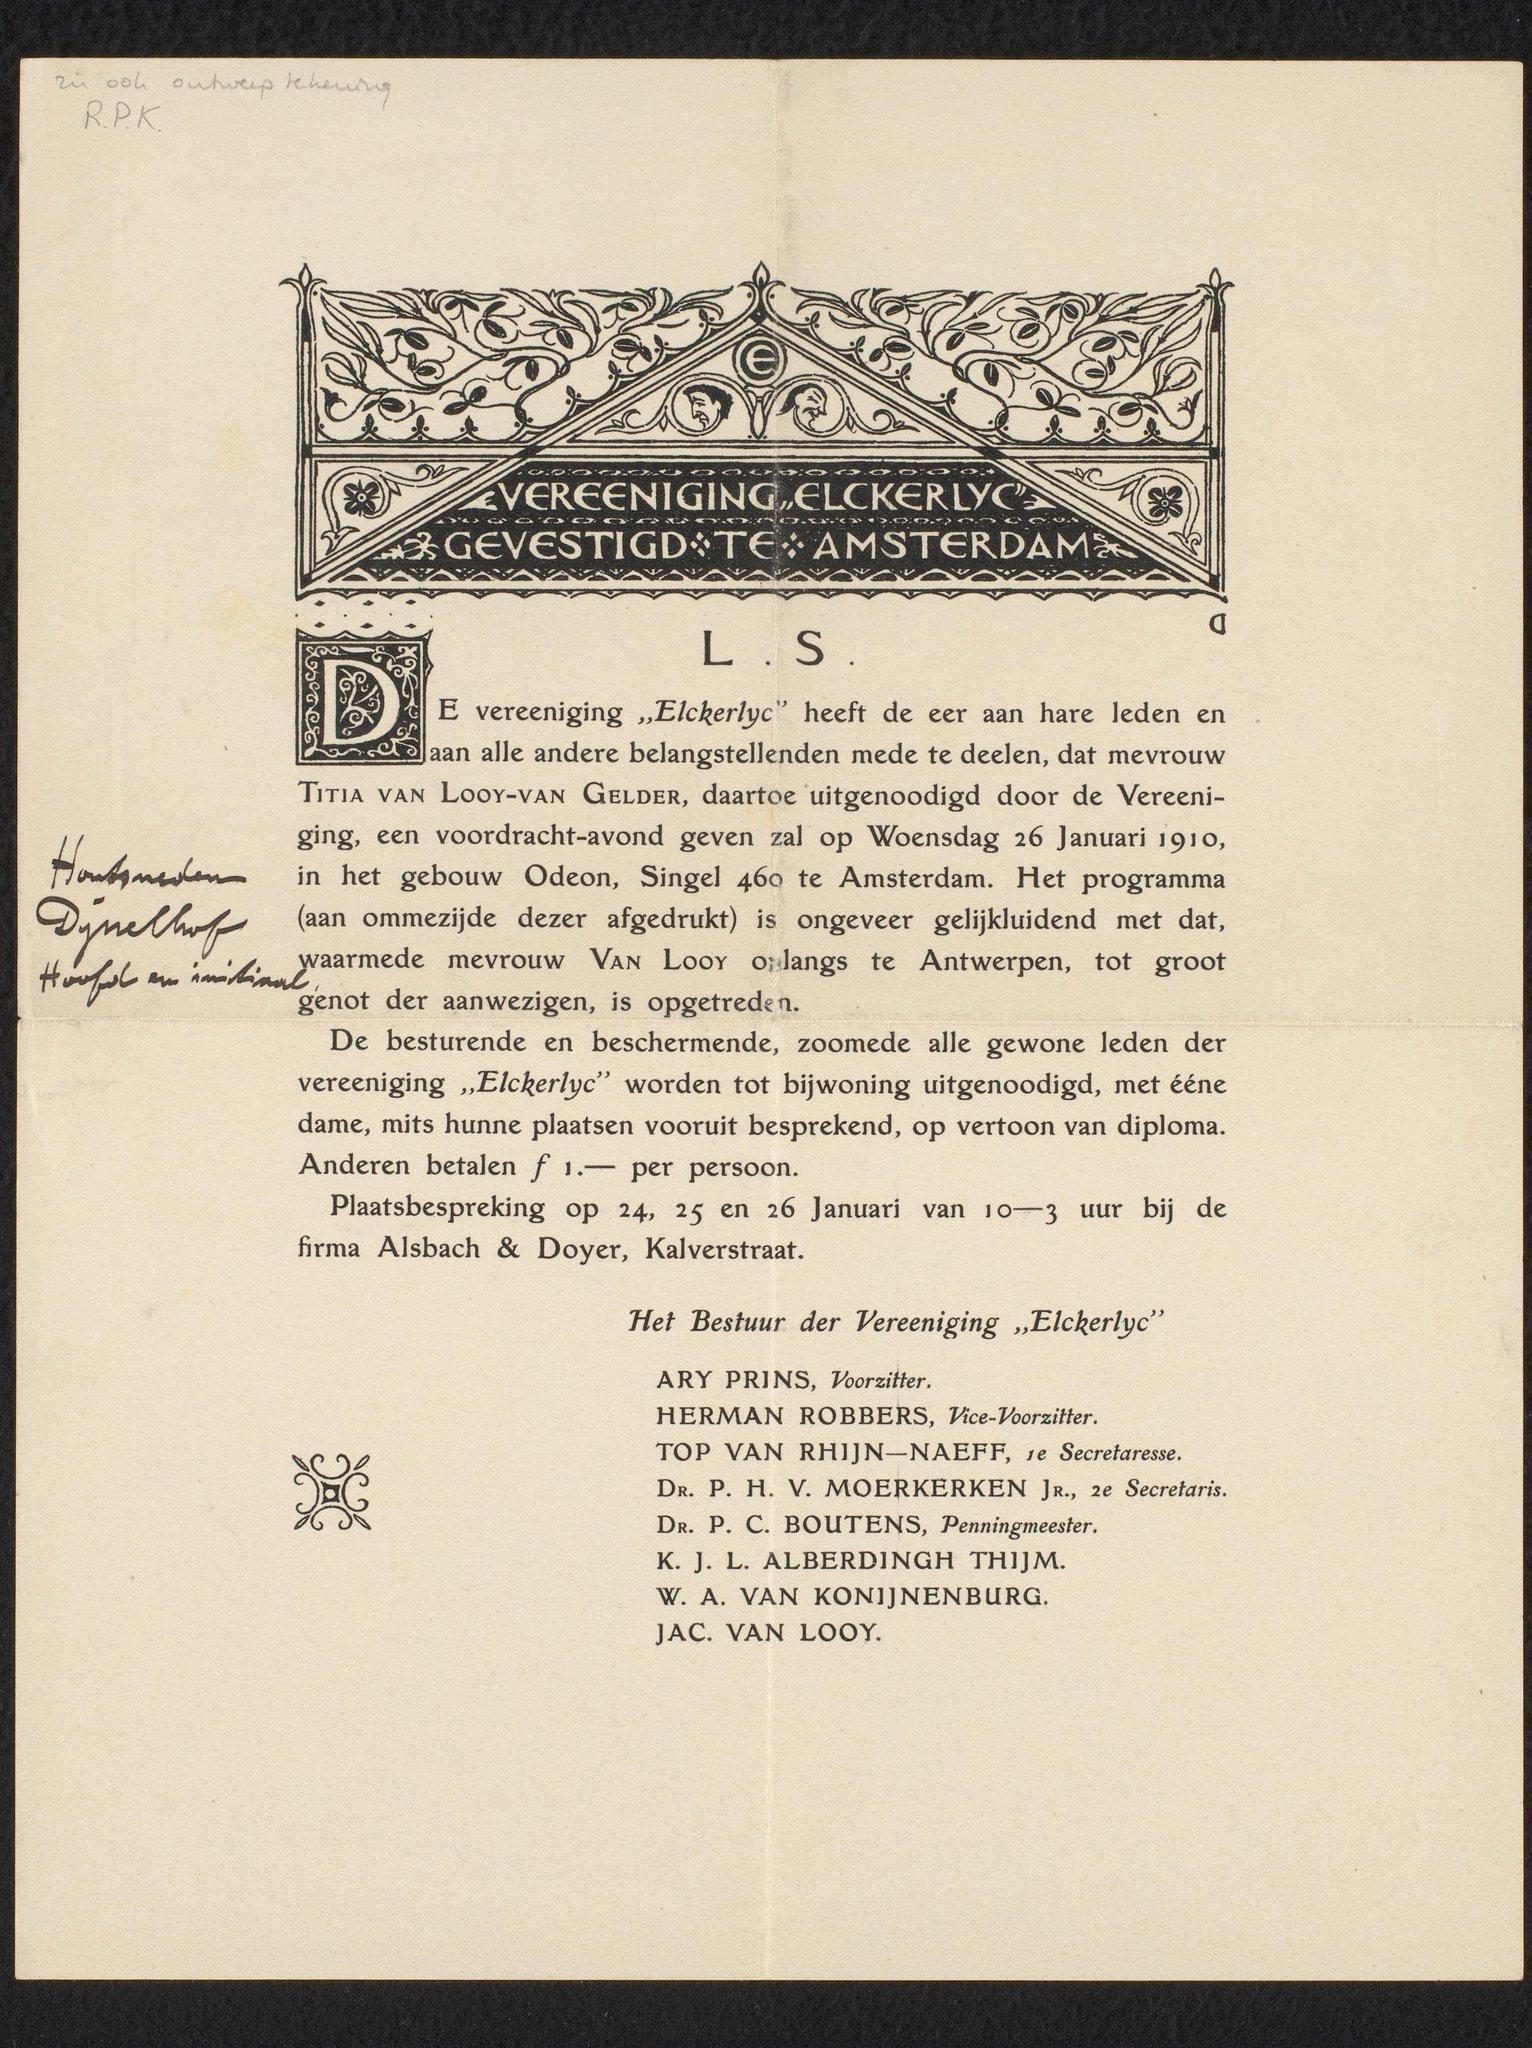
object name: programma, programmaboekje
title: Uitnodiging en programma voor de voordrachtavond van de Vereeniging Elckerlyc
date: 1908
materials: paper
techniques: printing block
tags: titia van looy-van gelder, ornaments ~ art, initial, amsterdam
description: Een briefhoofd en decoratief initiaal voorafgaand aan de tekst van de uitnodiging. Het programma van de middag, bestaande uit liederen en poëzie, op het verso.